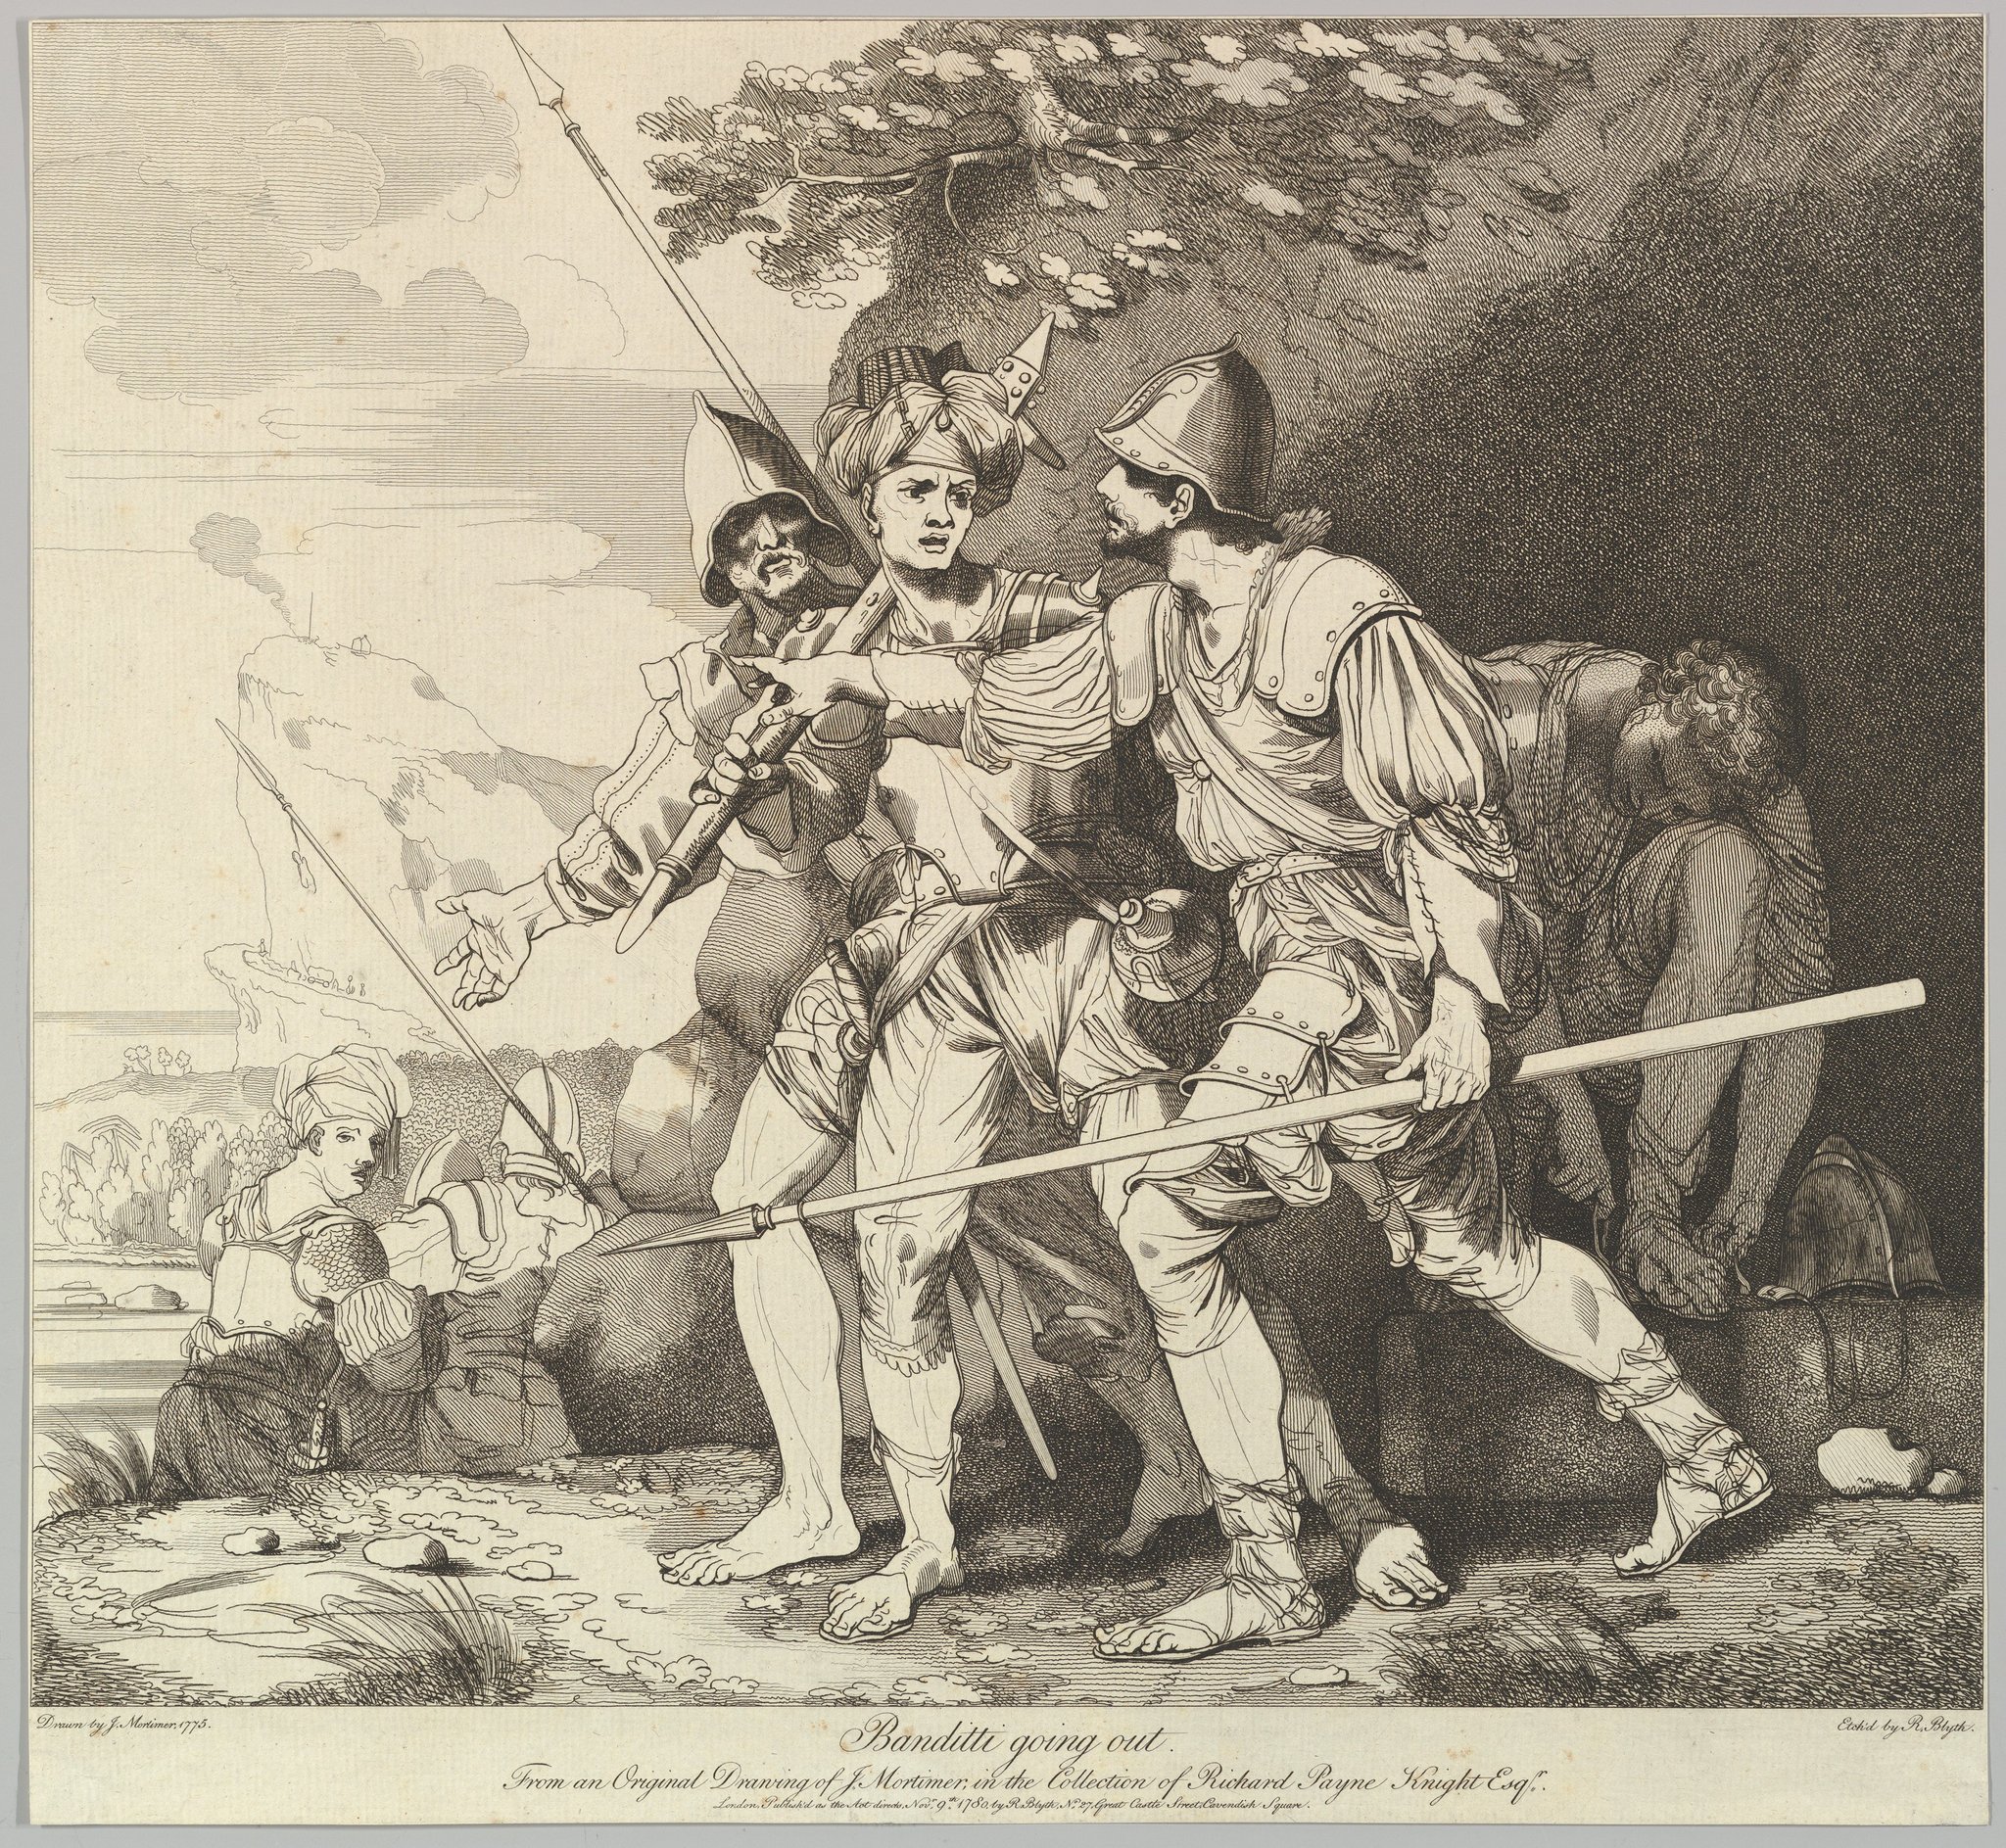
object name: print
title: Banditti Going Out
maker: robert blyth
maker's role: artist and publisher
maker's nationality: british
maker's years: 1750-1784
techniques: etching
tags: soldiers,spears